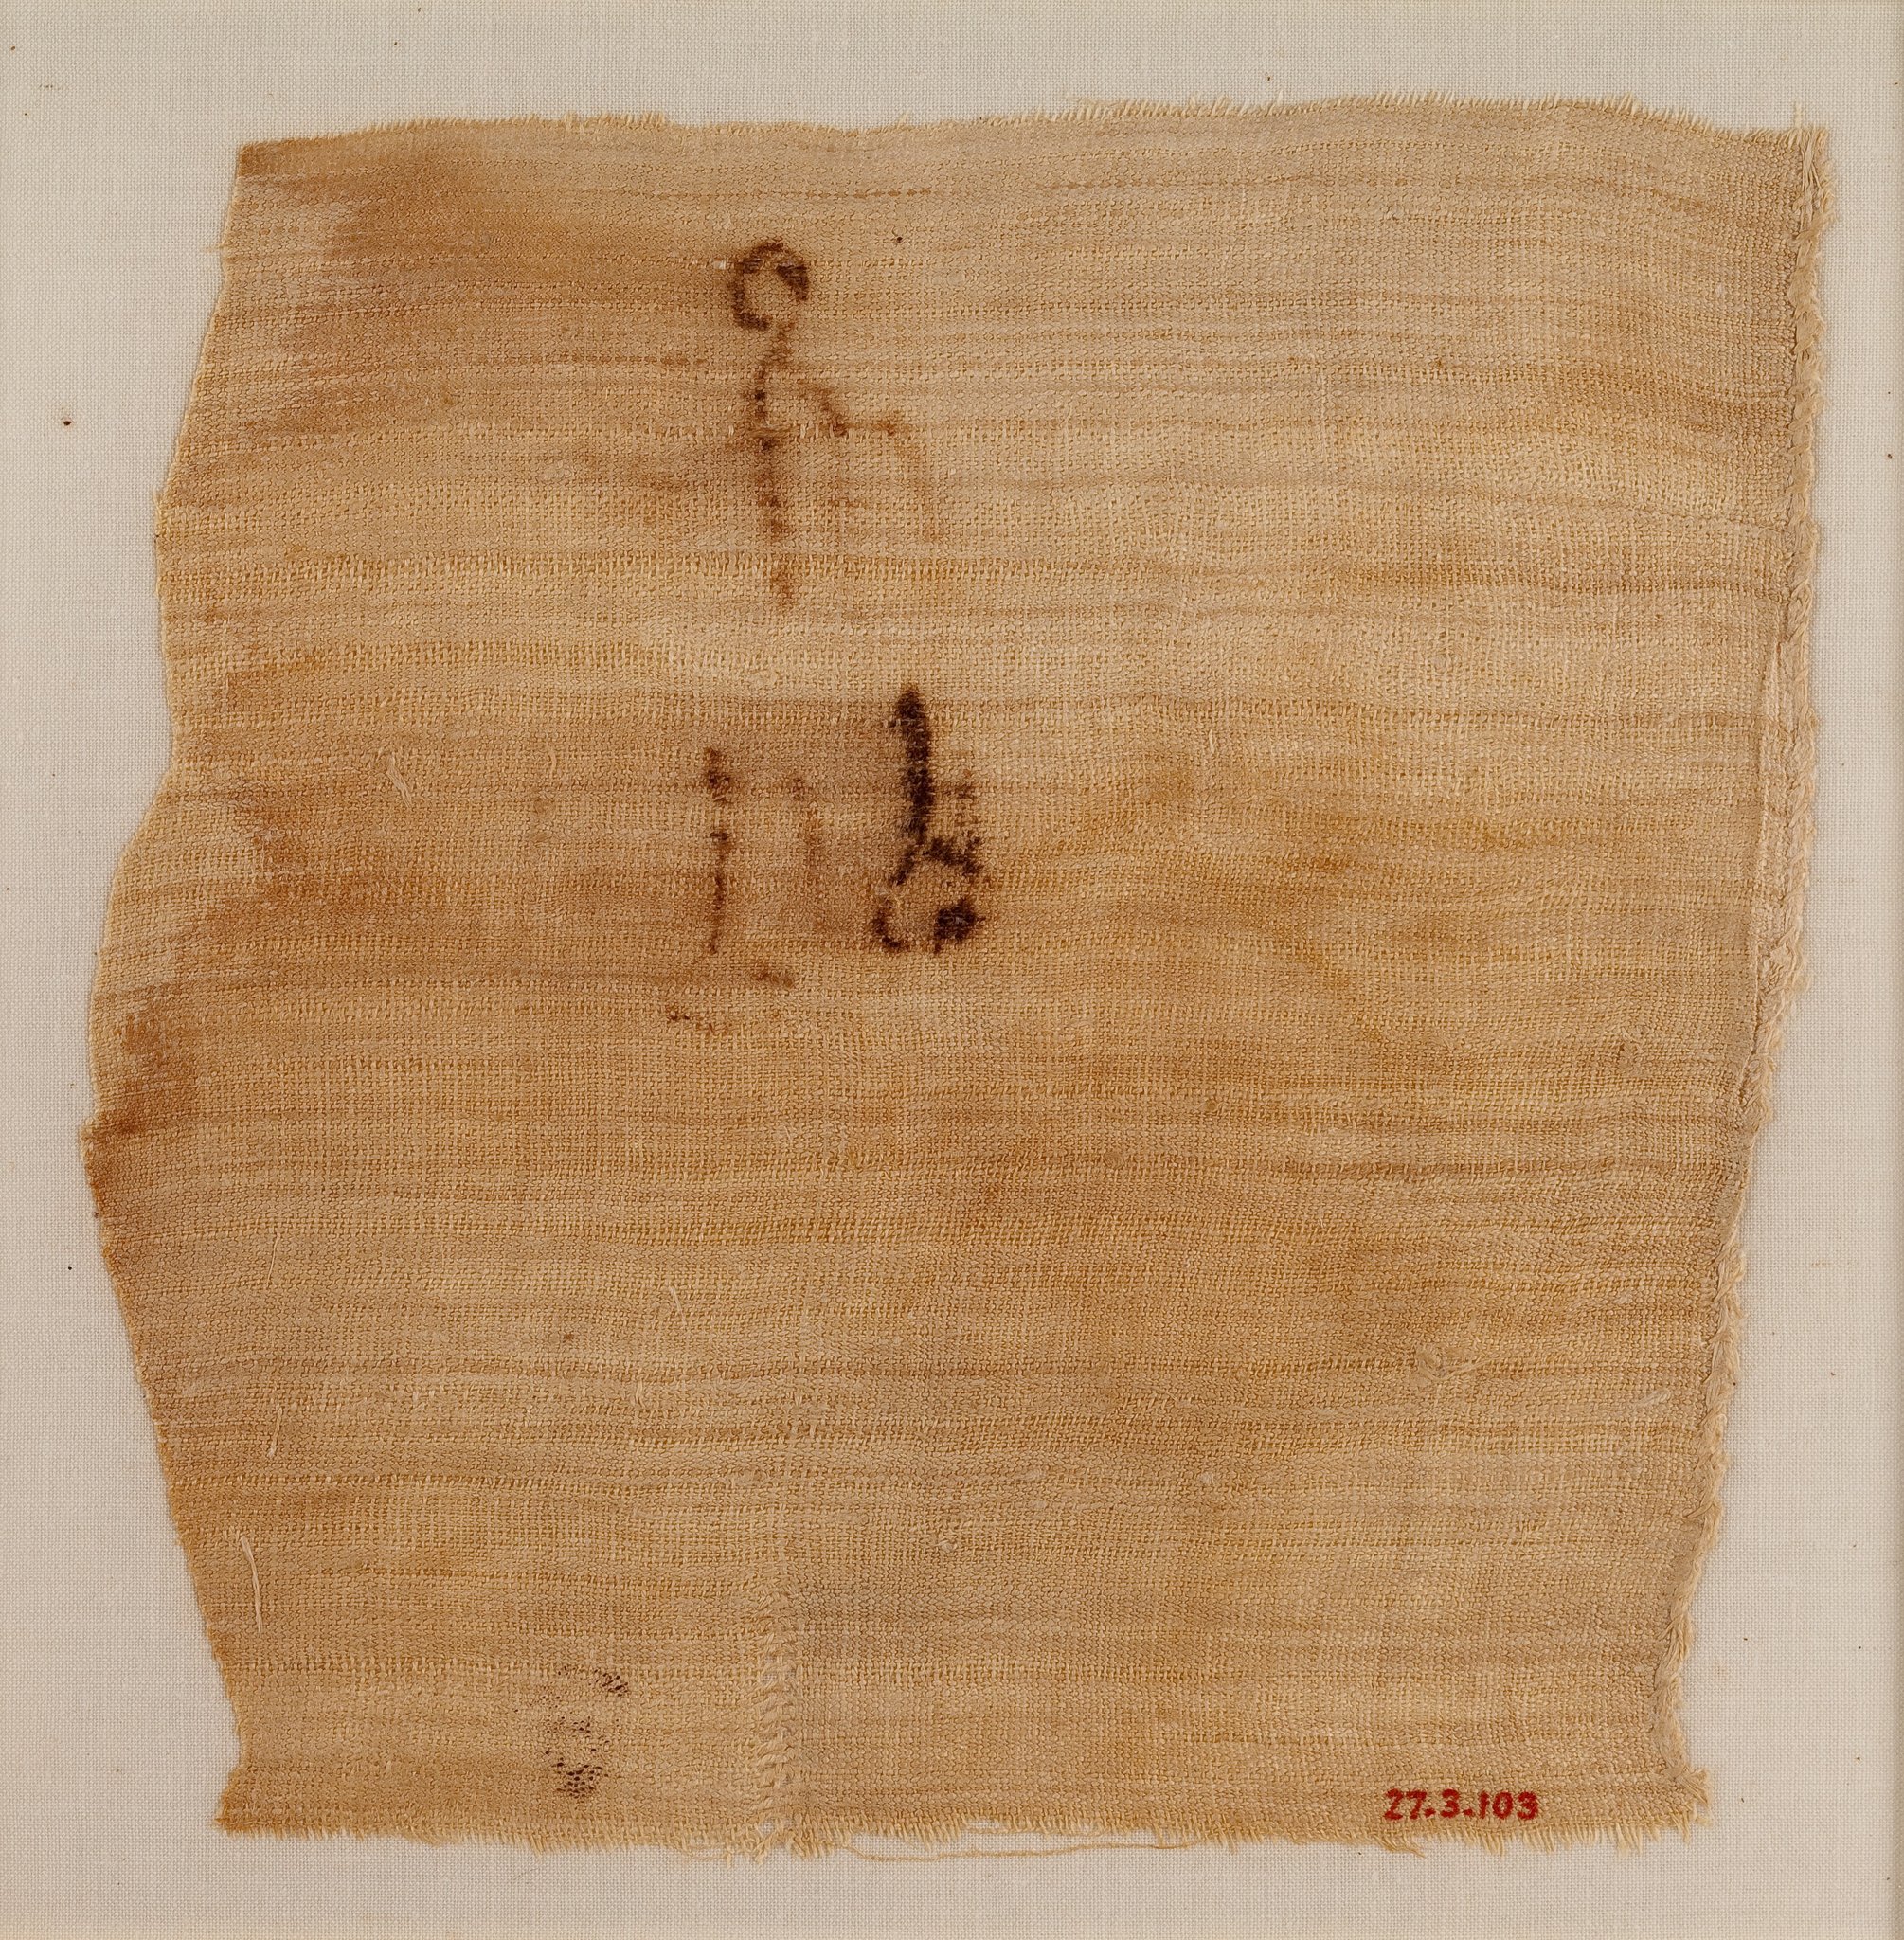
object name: linen mark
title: Linen mark (Type VIII)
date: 1961-1917 BCE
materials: linen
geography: egypt